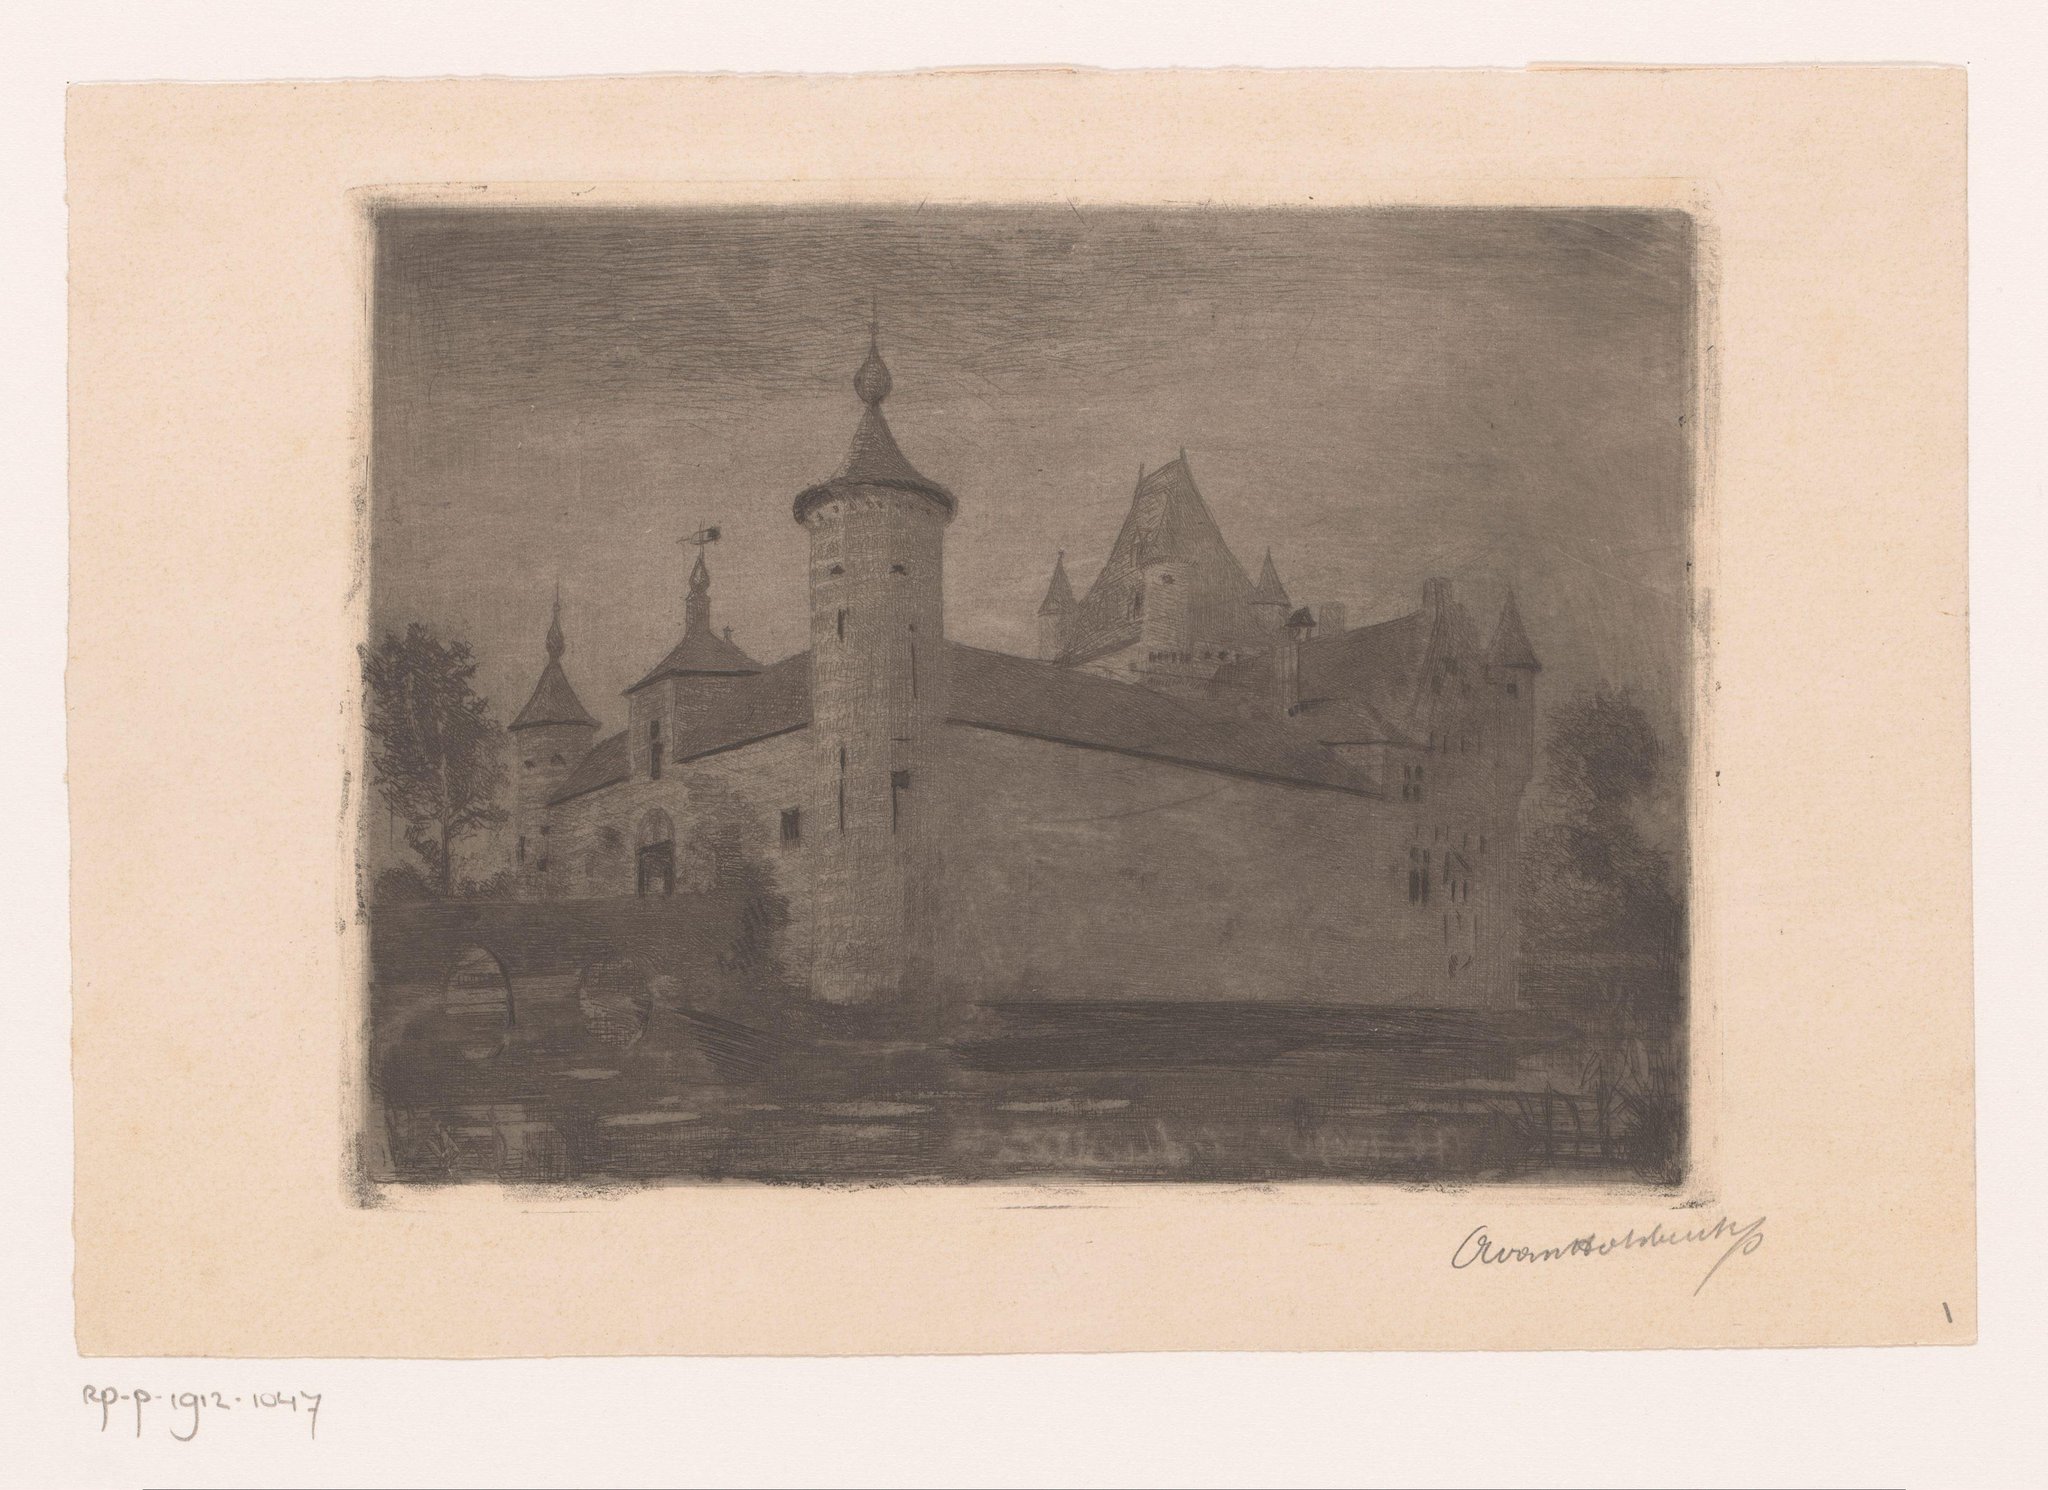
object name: print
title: Gezicht op kasteel Bossenstein bij Broechem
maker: albert van holsbeeck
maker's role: print maker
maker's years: 1877-1948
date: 1887-1912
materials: paper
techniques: etching, intaglio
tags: castle, landscape with tower or castle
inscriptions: collector's mark: Lugt 2228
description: Dit kasteel staat ook bekend als Allemanshof of Halmaleshof.